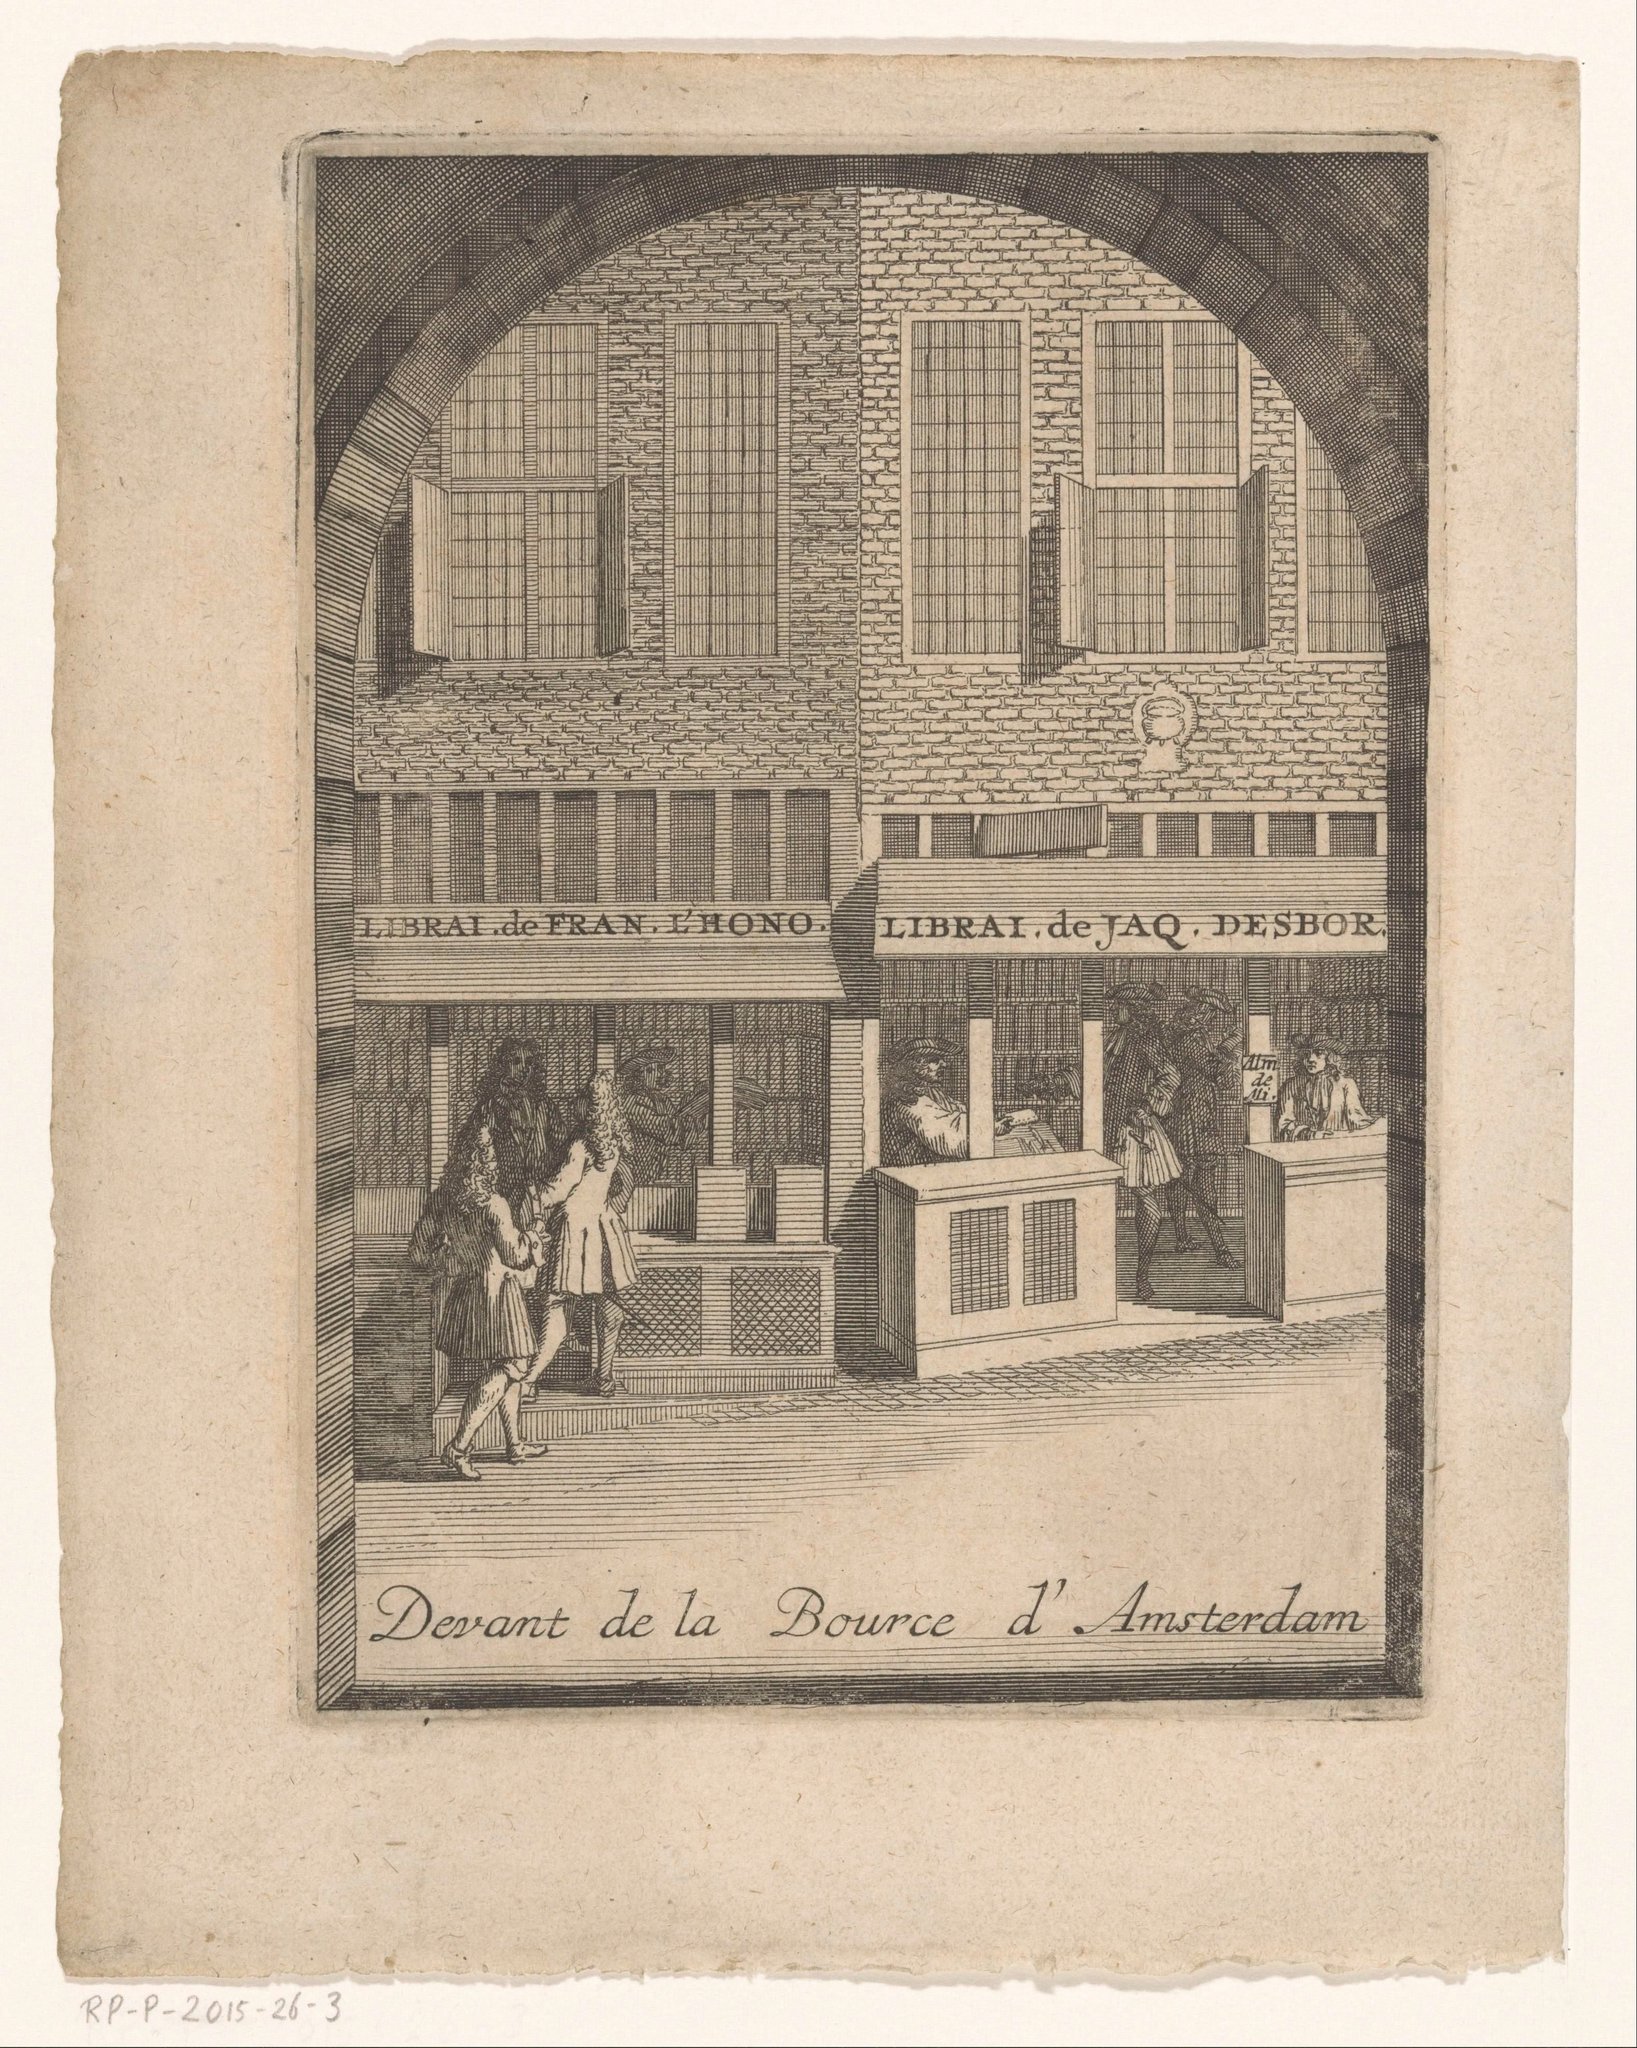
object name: print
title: Boekhandels van Francois L'Honoré en Jacques Desbordes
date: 1715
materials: paper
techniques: engraving, etching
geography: amsterdam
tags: city-view, and landscape with man-made constructions, book-shop, bookseller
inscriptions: collector's mark: Lugt 2228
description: Ook gebruikt in: Phoonsen, Johannes. Les loix et les coutumes du change des principales places de l'Europe. [Vertaald uit het Nederlands door] Jean Pierre Ricard. Amsterdam: E. Roger, 1715.